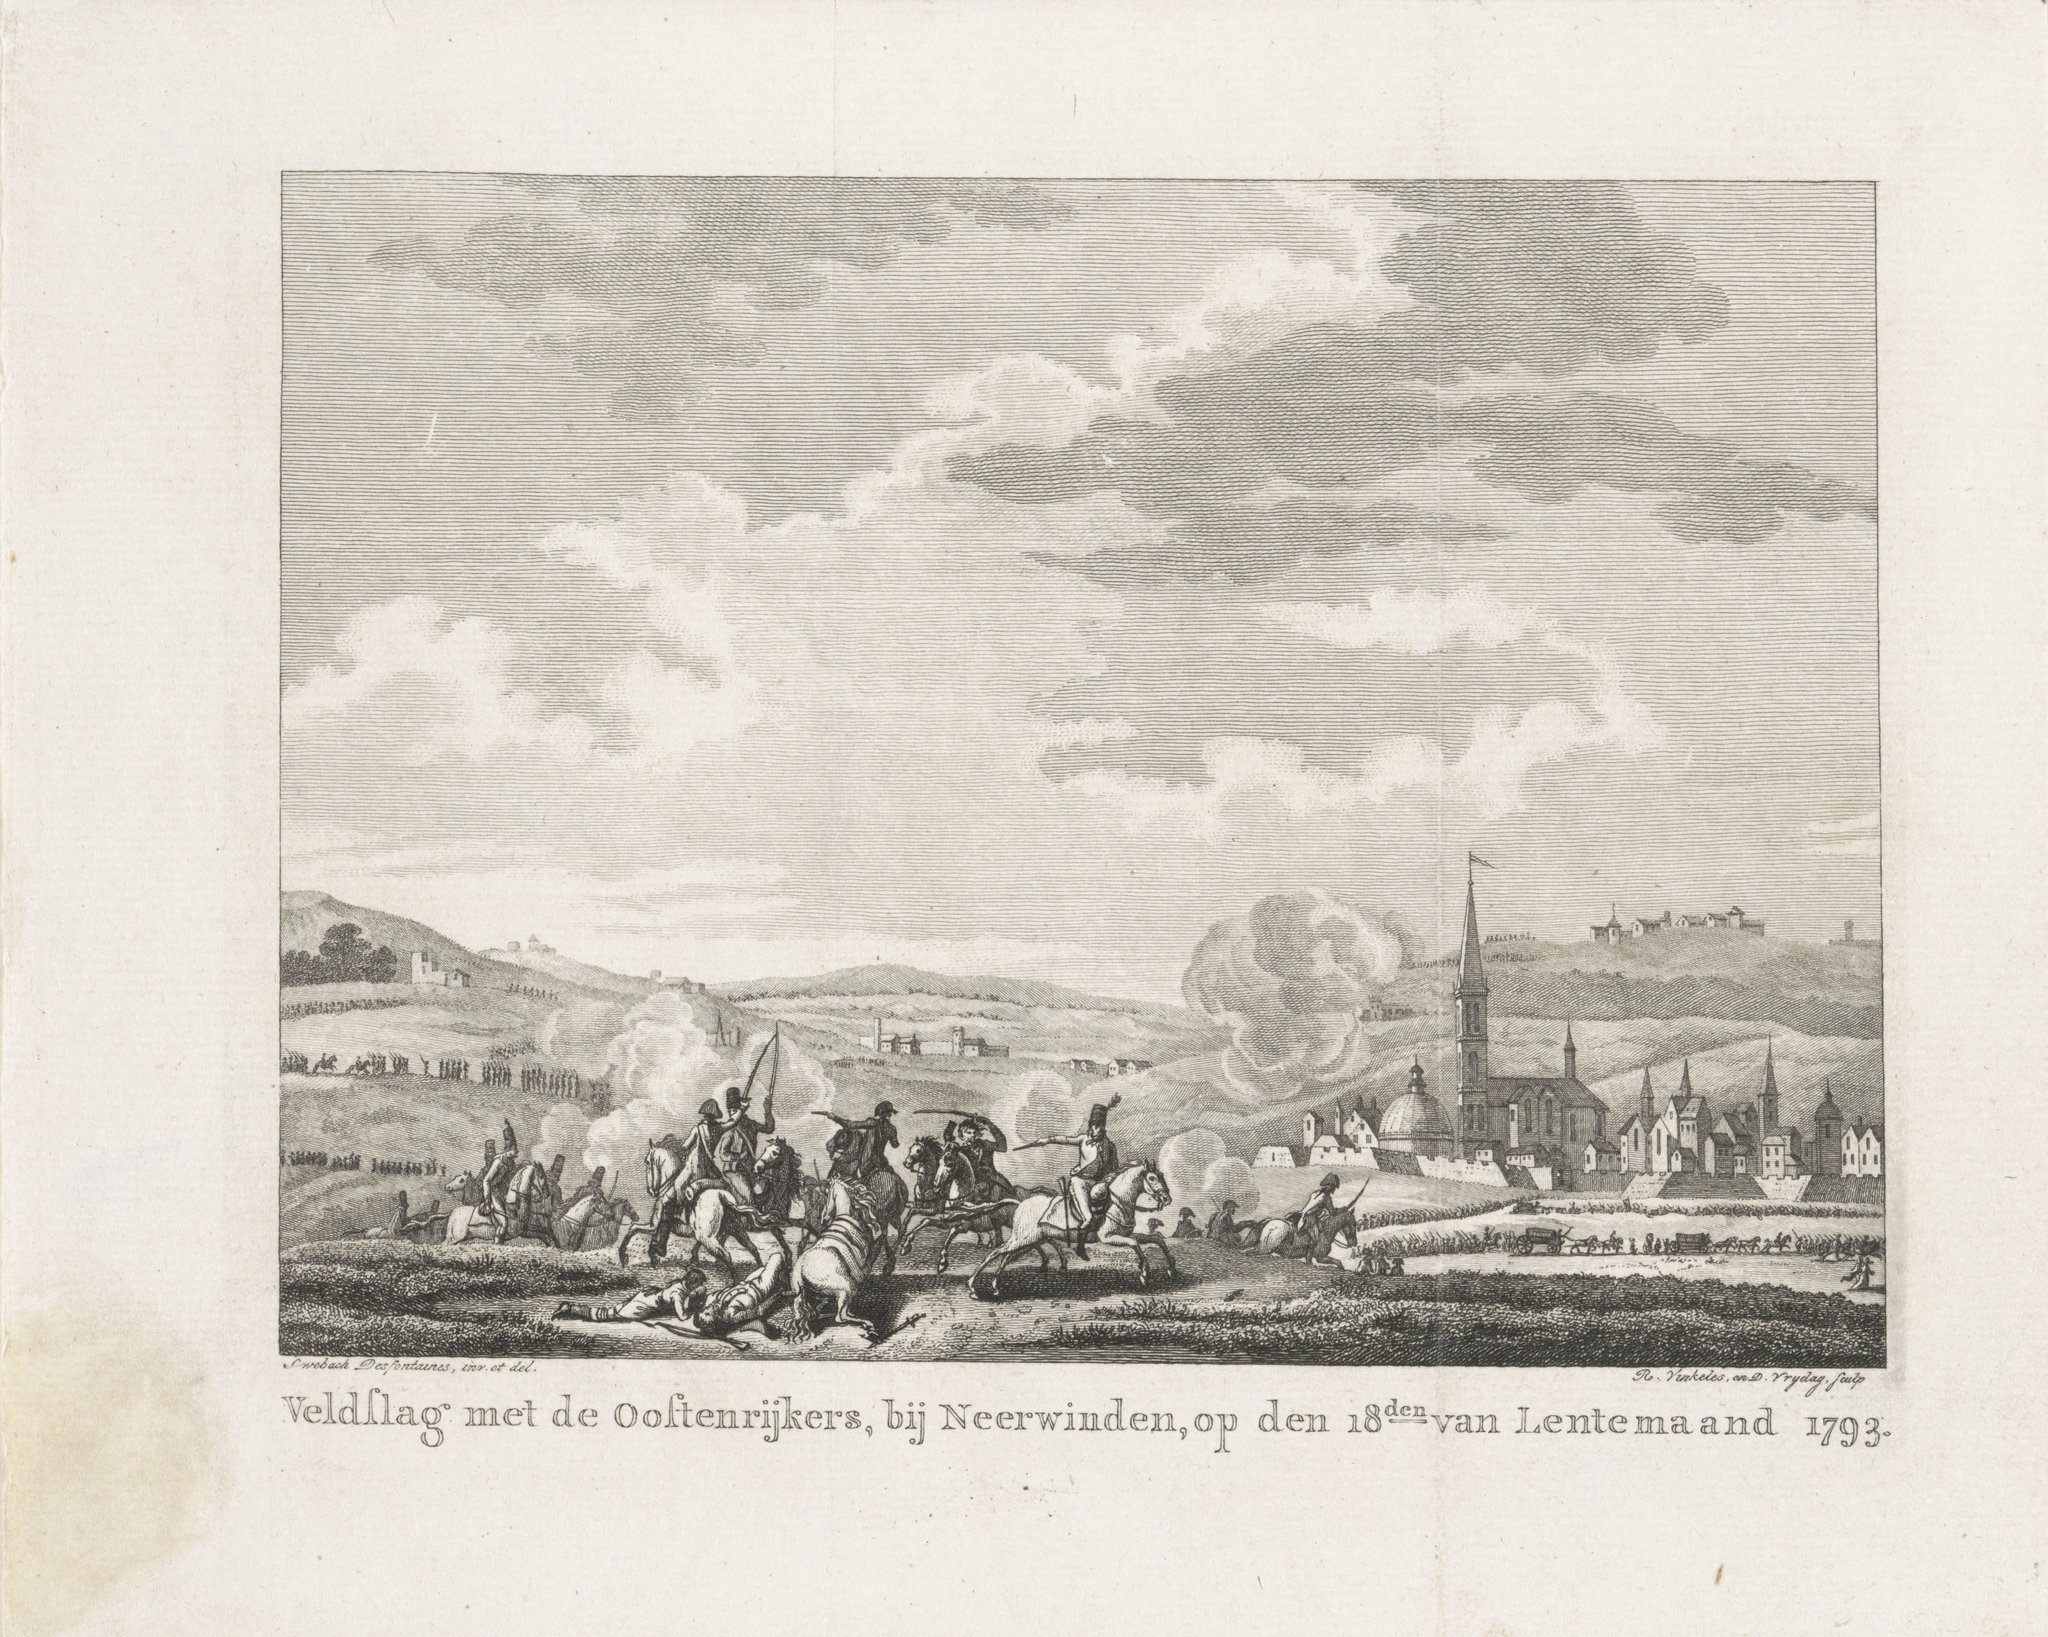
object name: print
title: Slag bij Neerwinden, 1793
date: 1794-1807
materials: paper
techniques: engraving, etching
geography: northern netherlands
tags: battle (+ land forces)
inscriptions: collector's mark: Lugt 2228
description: Gebruikt als illustratie in: Martinus Stuart en Johan Konijnenburg. Tafereelen van de staatsomwenteling in Frankrijk. Amsterdam: Johannes Allart, 28 dln, 1794-1807.